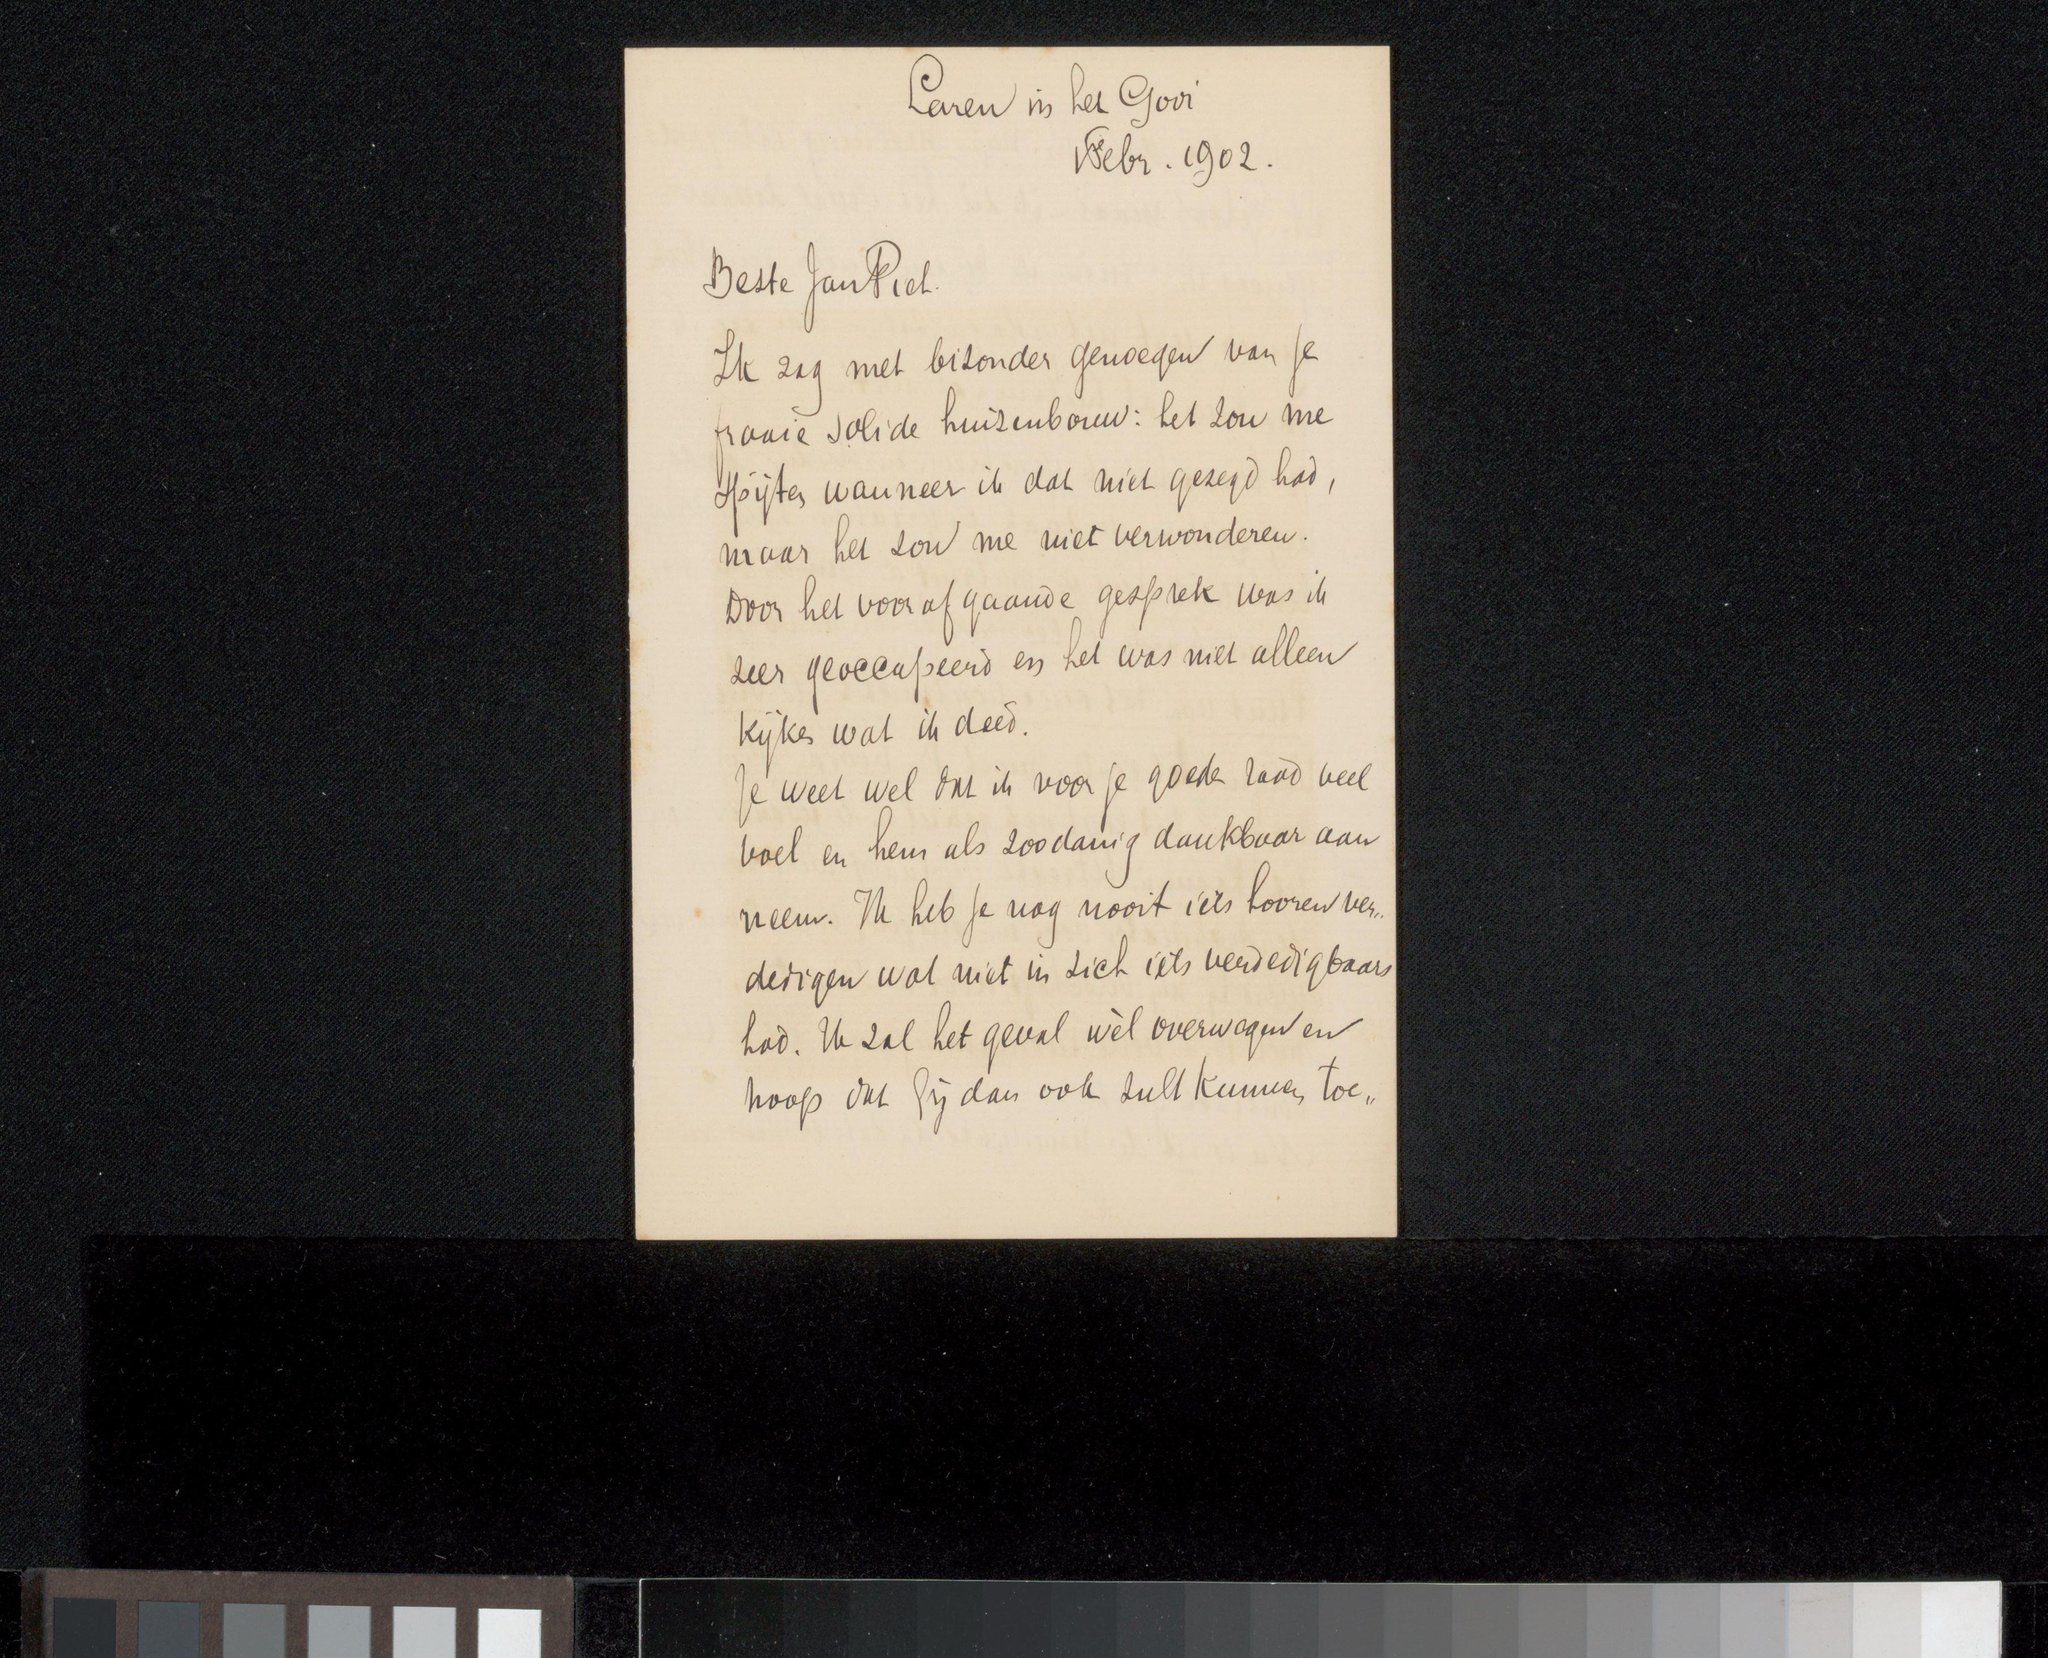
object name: letter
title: Brief aan Jan Veth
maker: antoon derkinderen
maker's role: draughtsman, painter, print maker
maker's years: 1859-1925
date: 1902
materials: ink, paper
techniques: pen, writing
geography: laren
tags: dordrecht, painter, print maker, draughtsman, designer, jan veth, hendrik petrus berlage, the monumental arts, money, utrecht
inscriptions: collector's mark: ‘RPK’